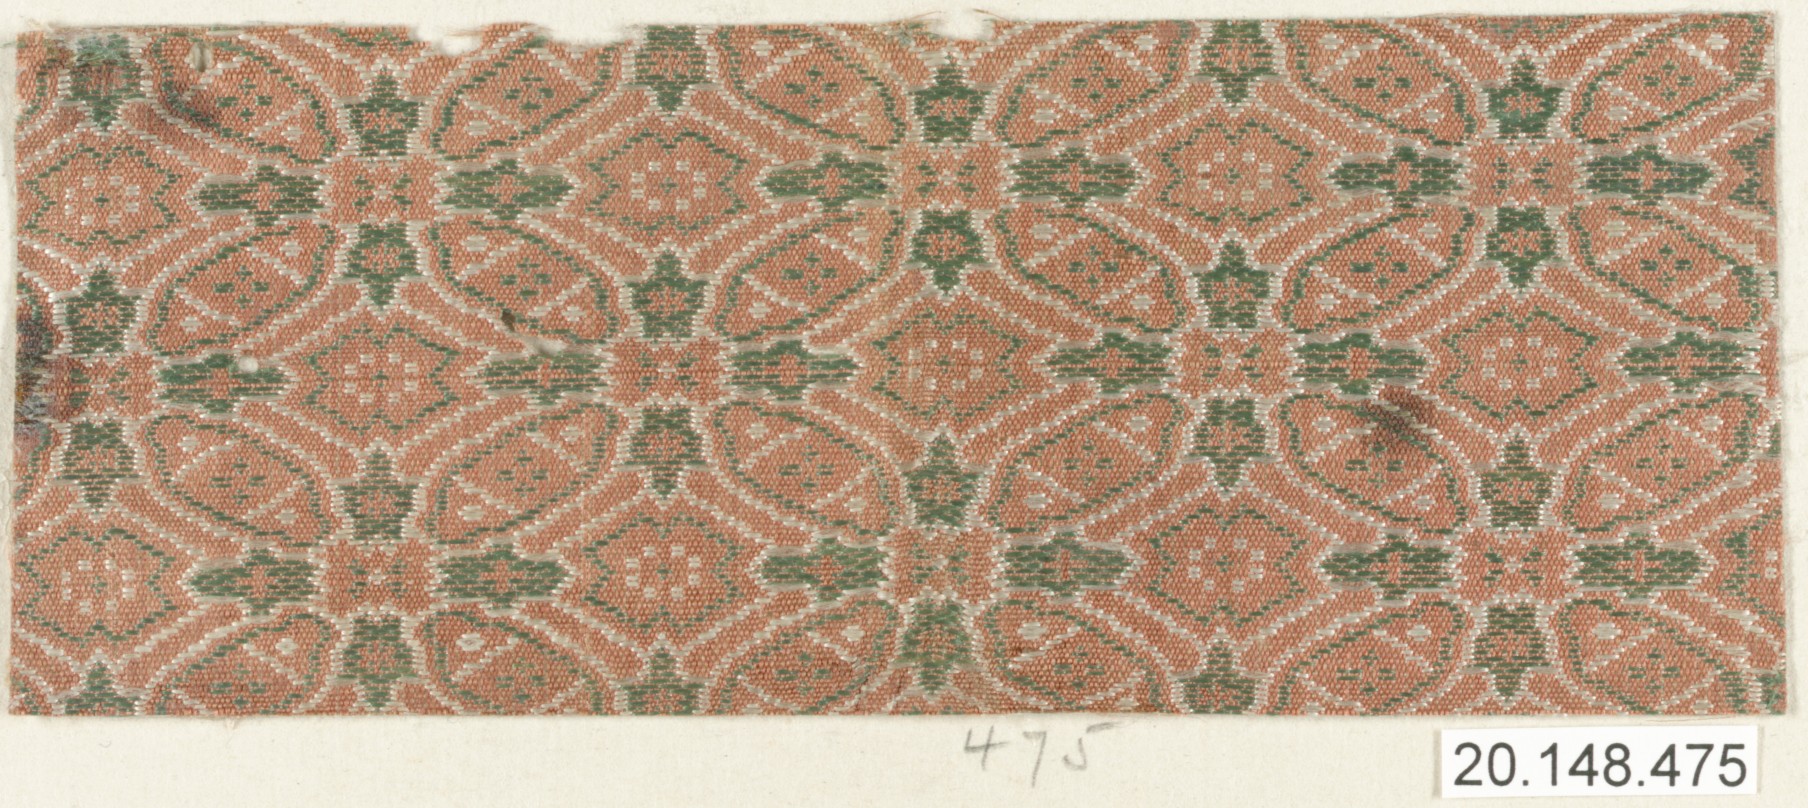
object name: piece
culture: japanese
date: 1601-1700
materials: silk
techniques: compound weave